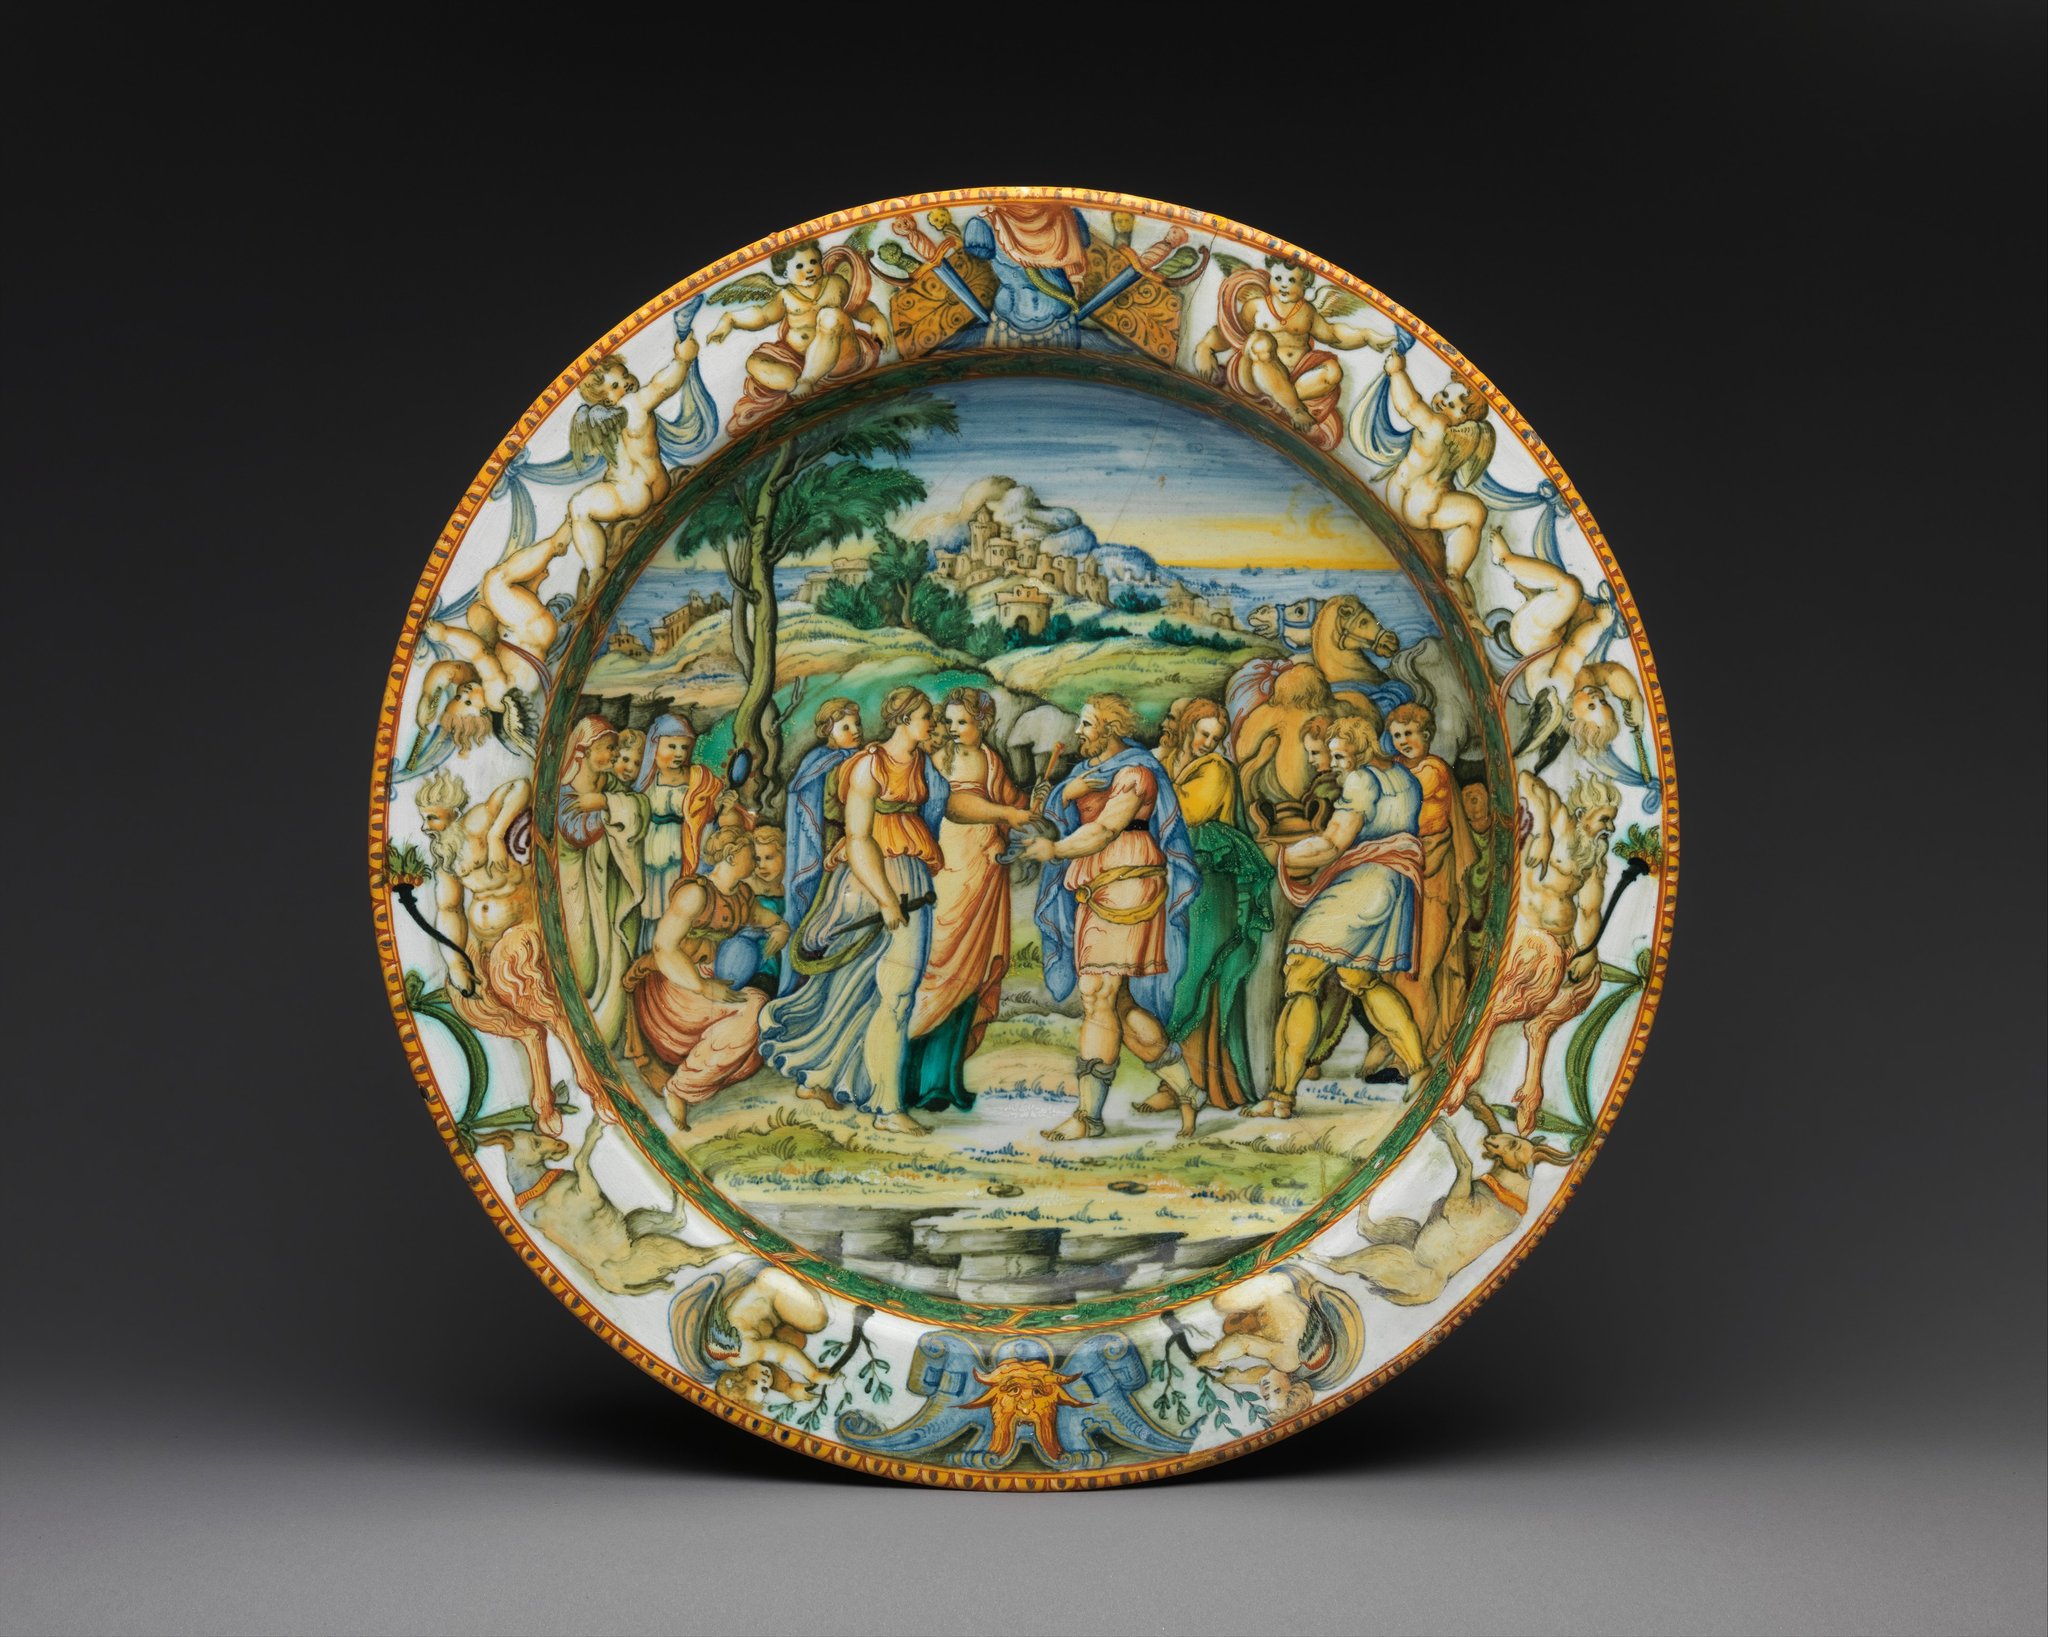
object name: dish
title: Dish with The Discovery of Achilles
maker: fontana workshops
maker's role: maker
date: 1555-1560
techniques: maiolica, glazing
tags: men,women,achilles,horses